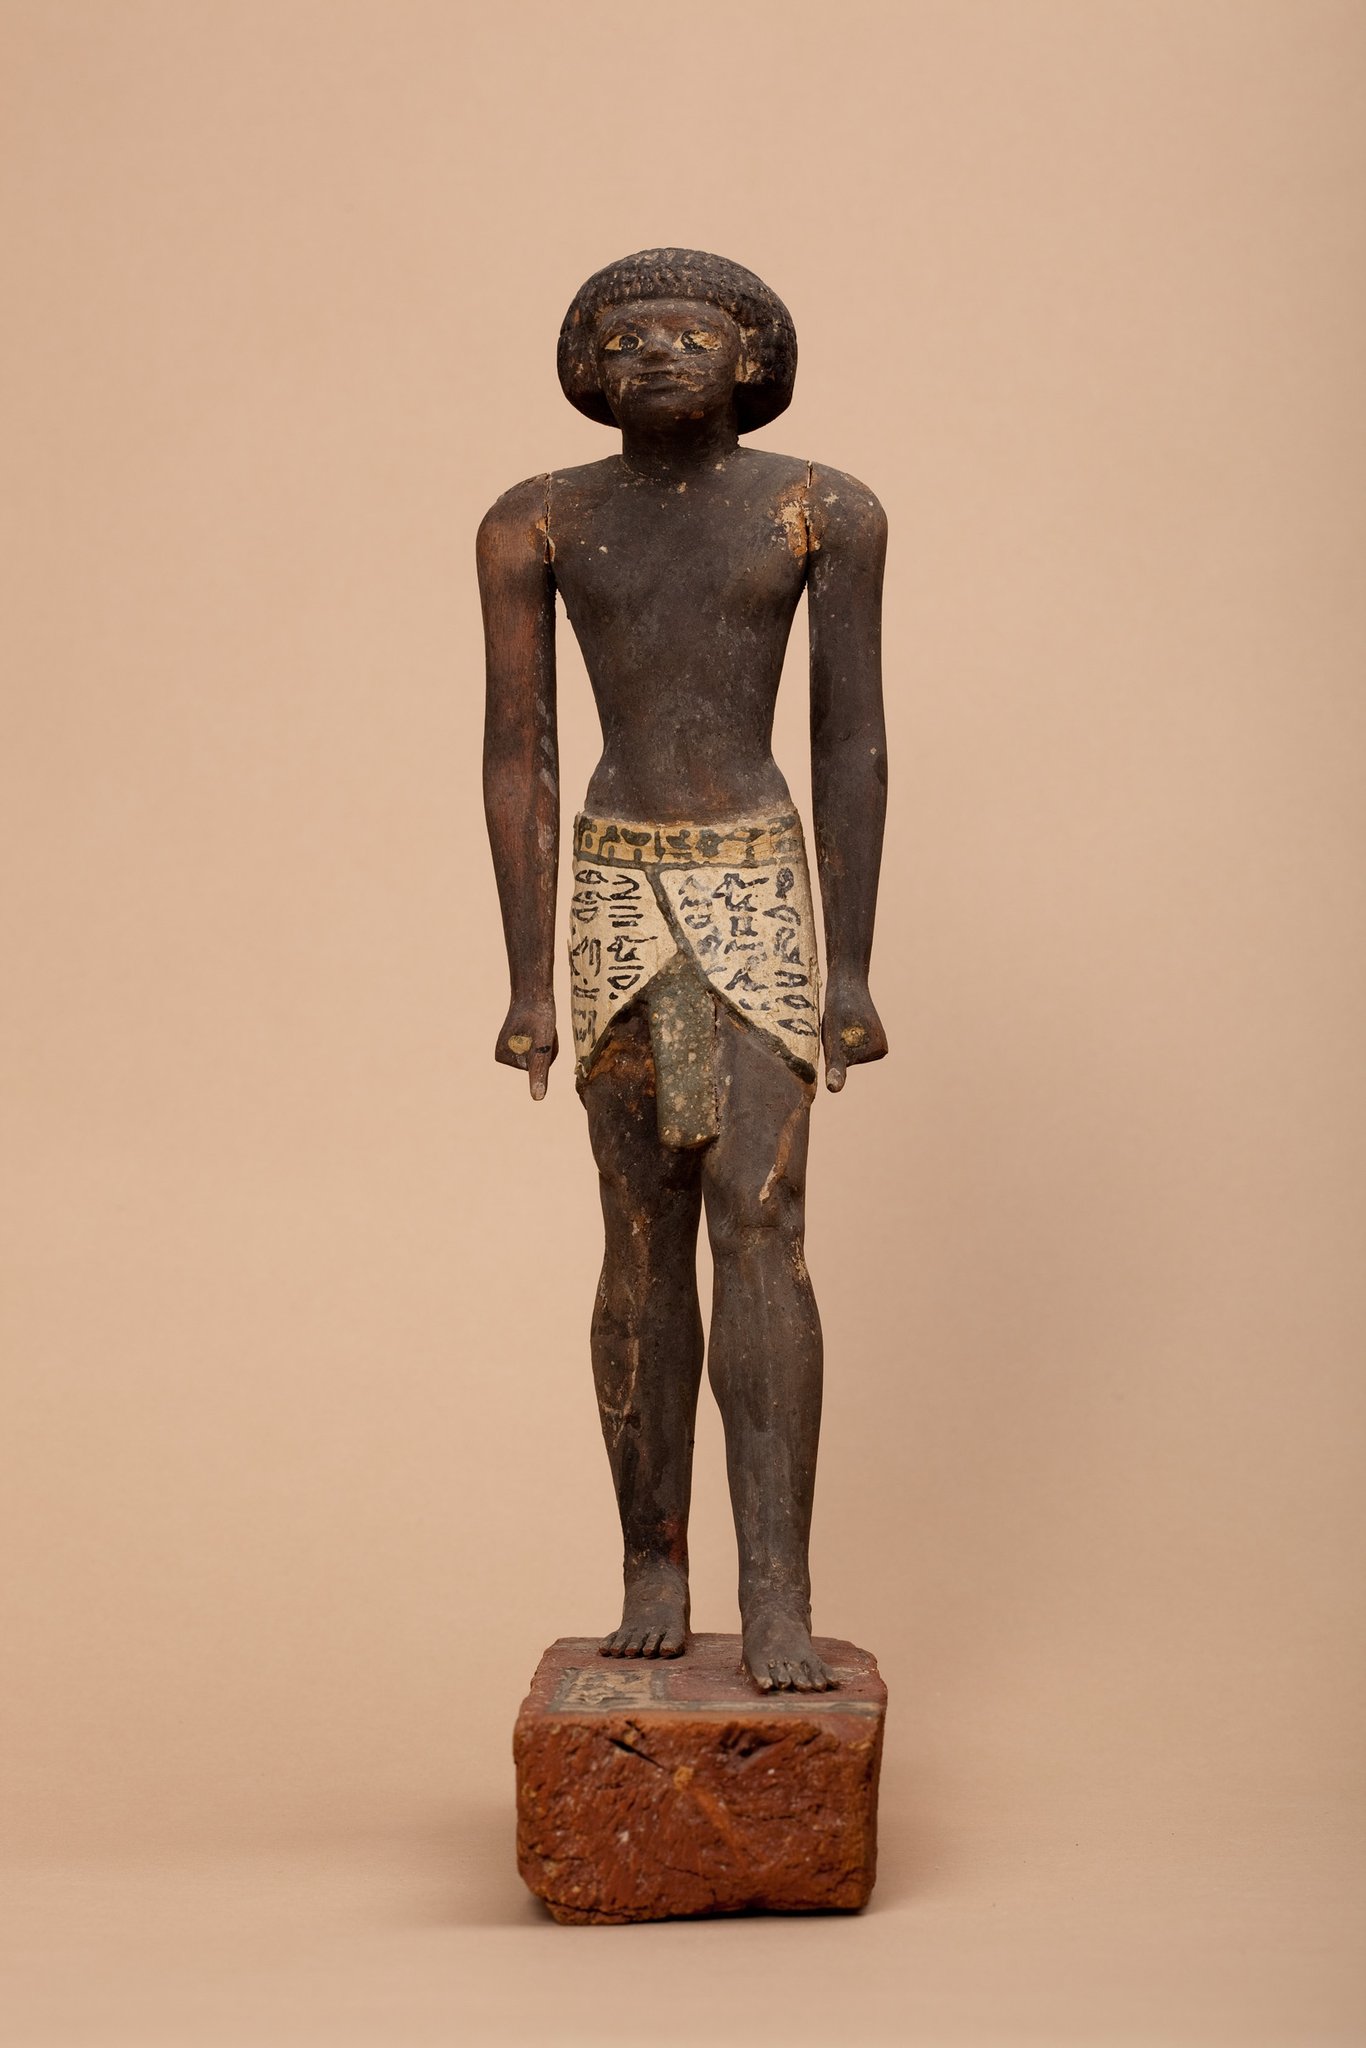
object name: statuette, merer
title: Statuette of Merer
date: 1981-1802 BCE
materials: gesso, paint, wood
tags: men